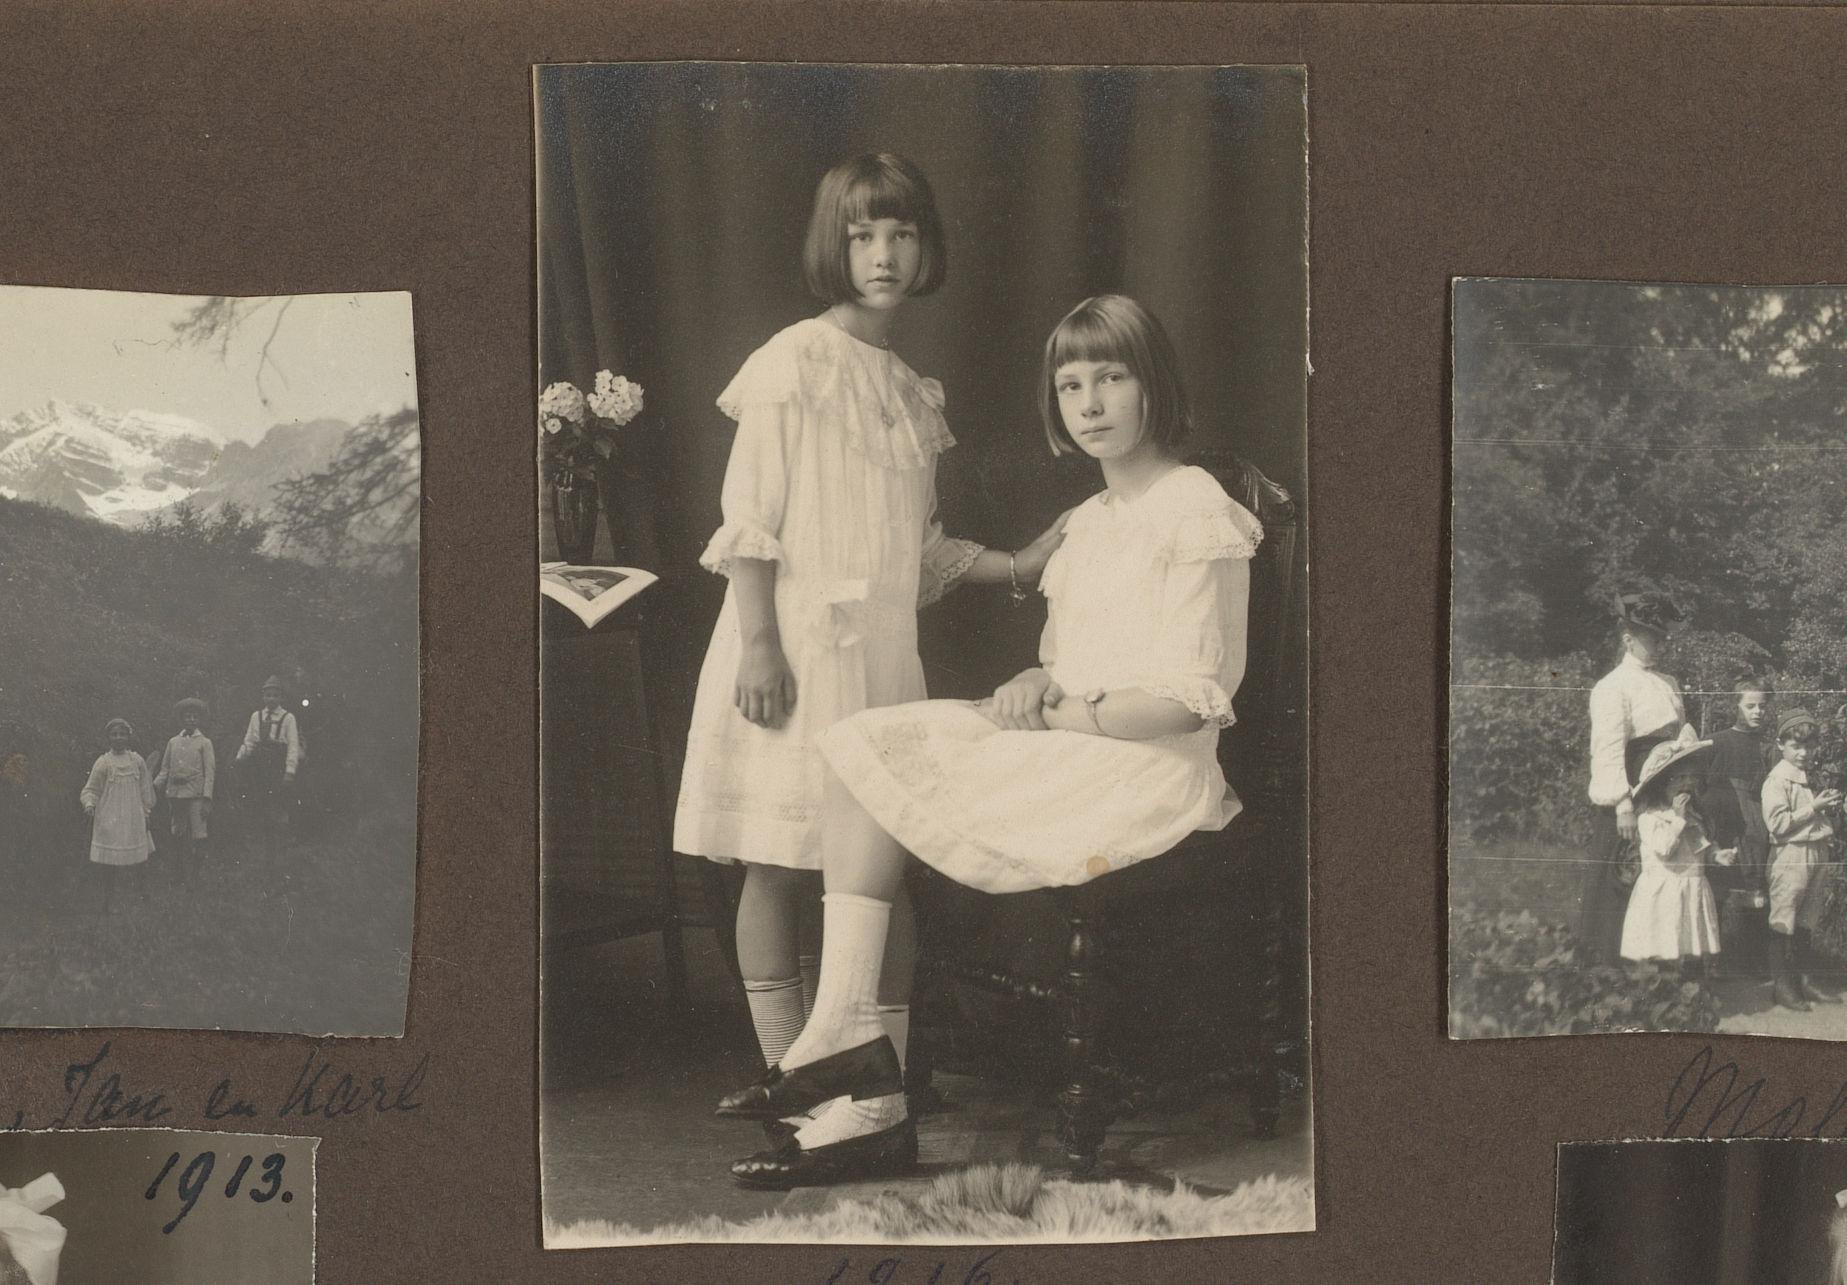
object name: photograph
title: Portret van Thea Diepenbrock staand en Joanna Diepenbrock zittend op een stoel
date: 1916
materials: paper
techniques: gelatin silver print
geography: netherlands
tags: amsterdam, historical persons - bb - woman, girl (child between toddler and youth), chair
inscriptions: date: ‘1916.’